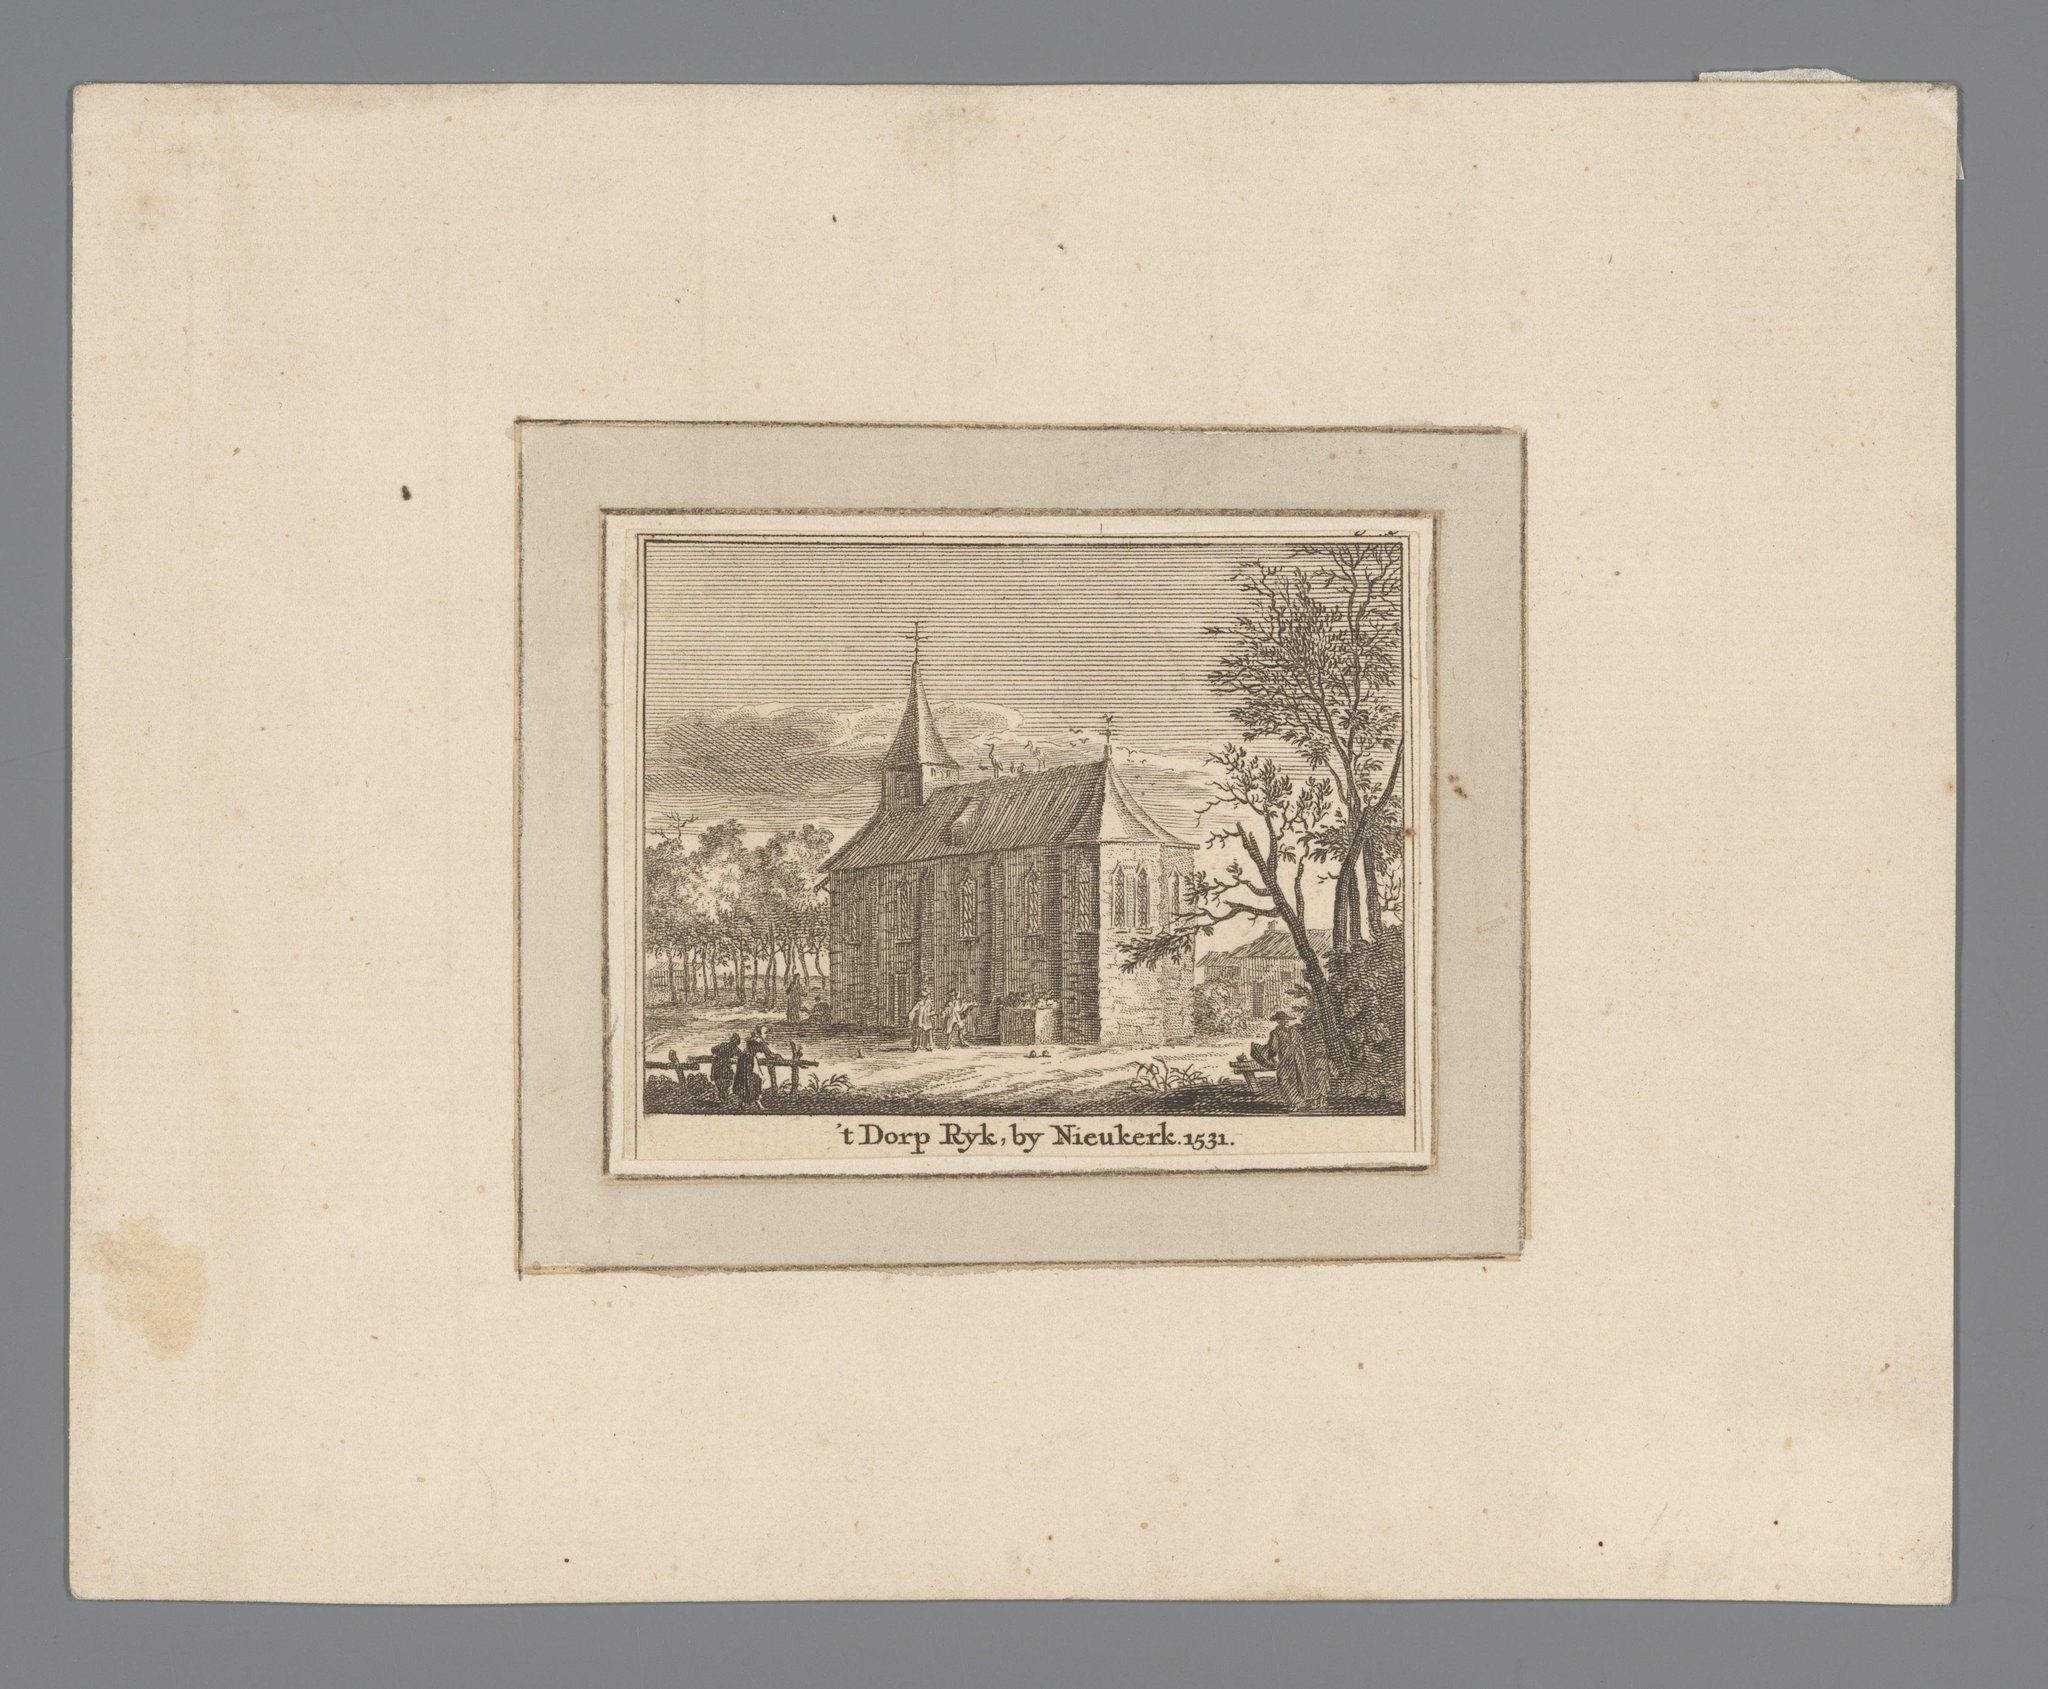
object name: print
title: 't Dorp Ryk, by Nieukerk. 1531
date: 1723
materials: paper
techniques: etching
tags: city-view, and landscape with man-made constructions, roman catholic church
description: Prent verschenen in: Willink, Daniel. Amsterdamsche Buitensingel Nevens de omleggende. Amsterdam: A. van Damme, 1723. Het dorp Rijk ofwel Rietwijk genaamd, is een voormalig dorp in Noord-Holland.